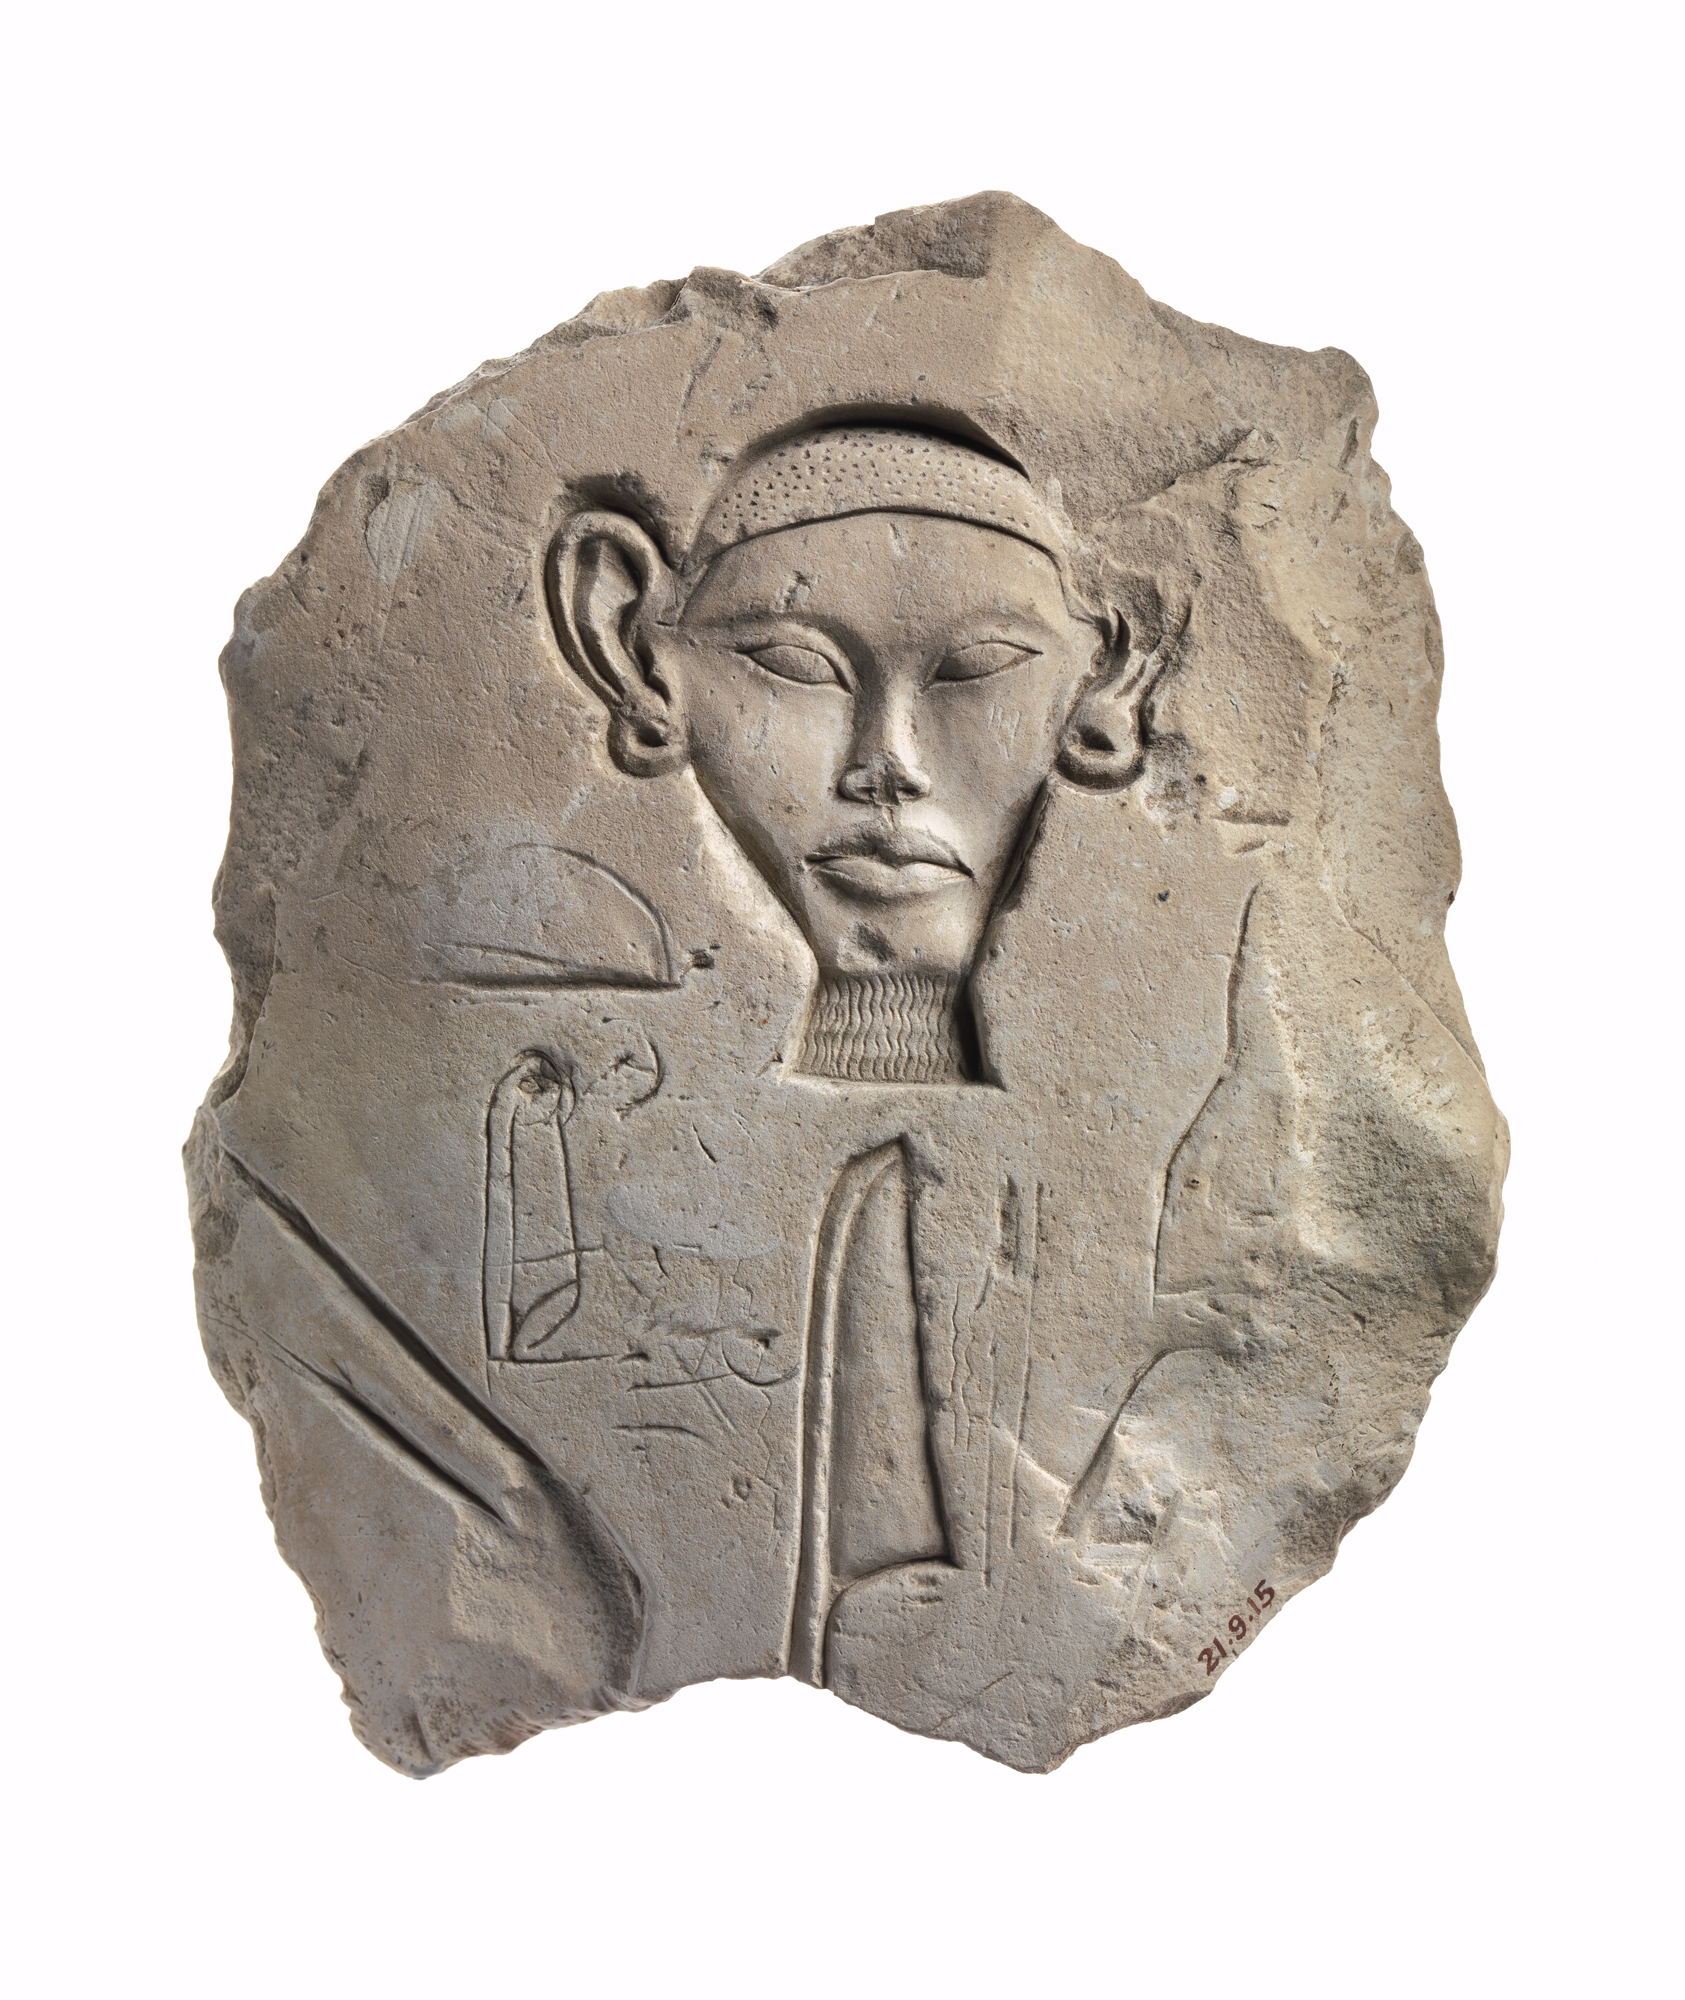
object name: trial piece, hieroglyph, face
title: Trial piece with hieroglyphs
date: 1353-1336 BCE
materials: limestone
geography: egypt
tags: faces,hieroglyphs